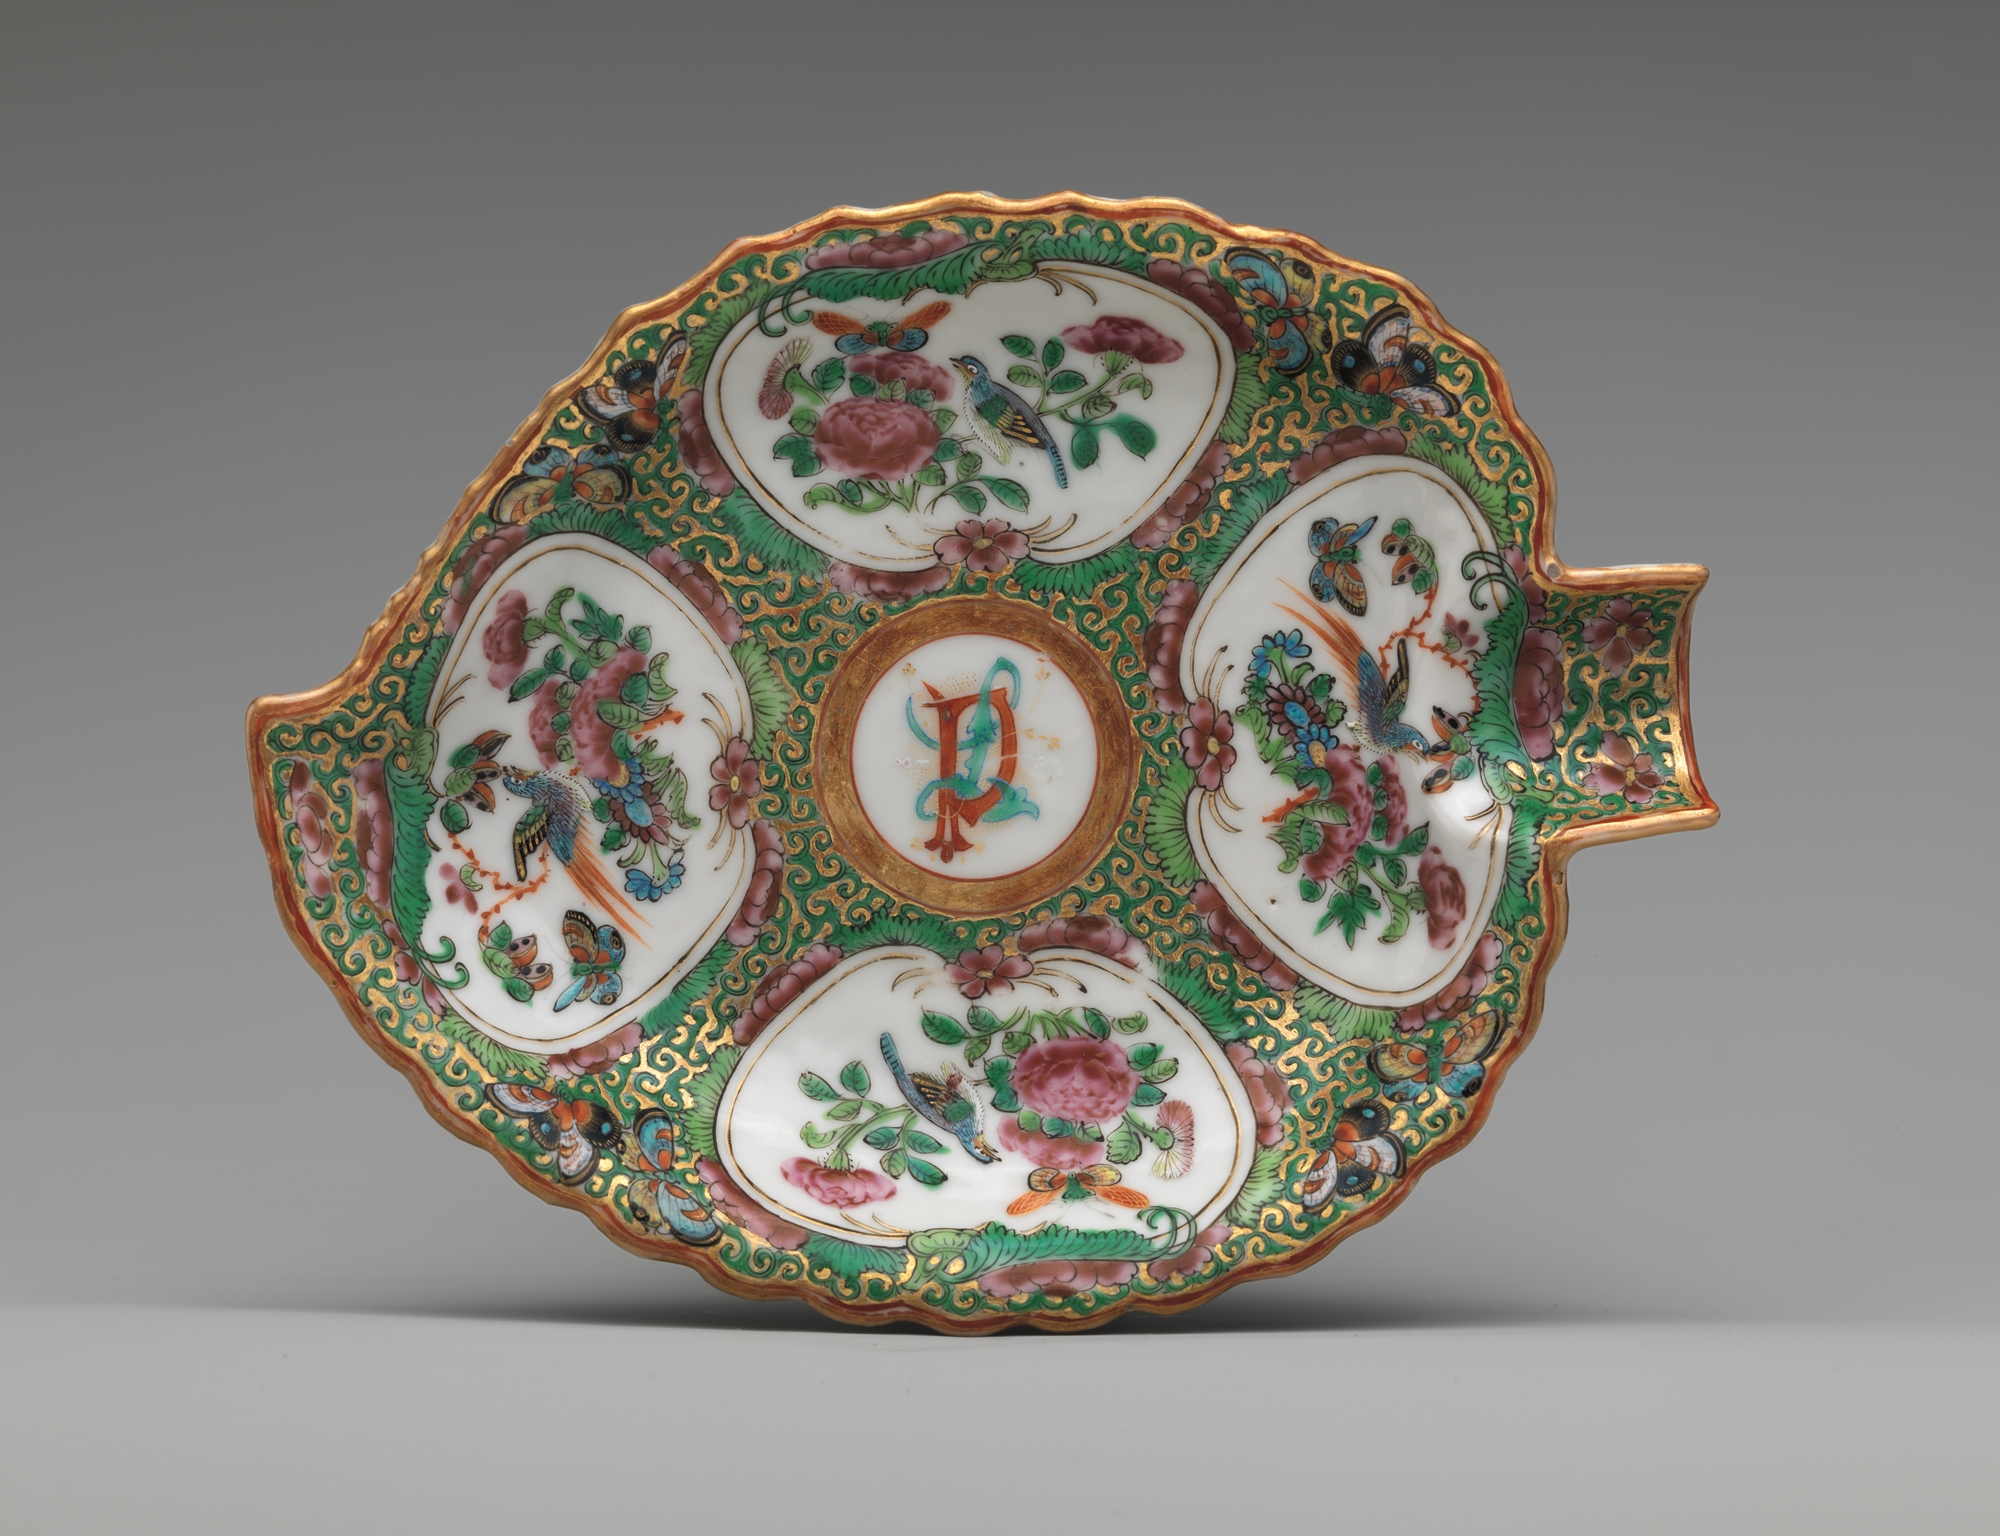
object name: dish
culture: chinese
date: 1860-1866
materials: porcelain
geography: china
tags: birds,butterflies,flowers